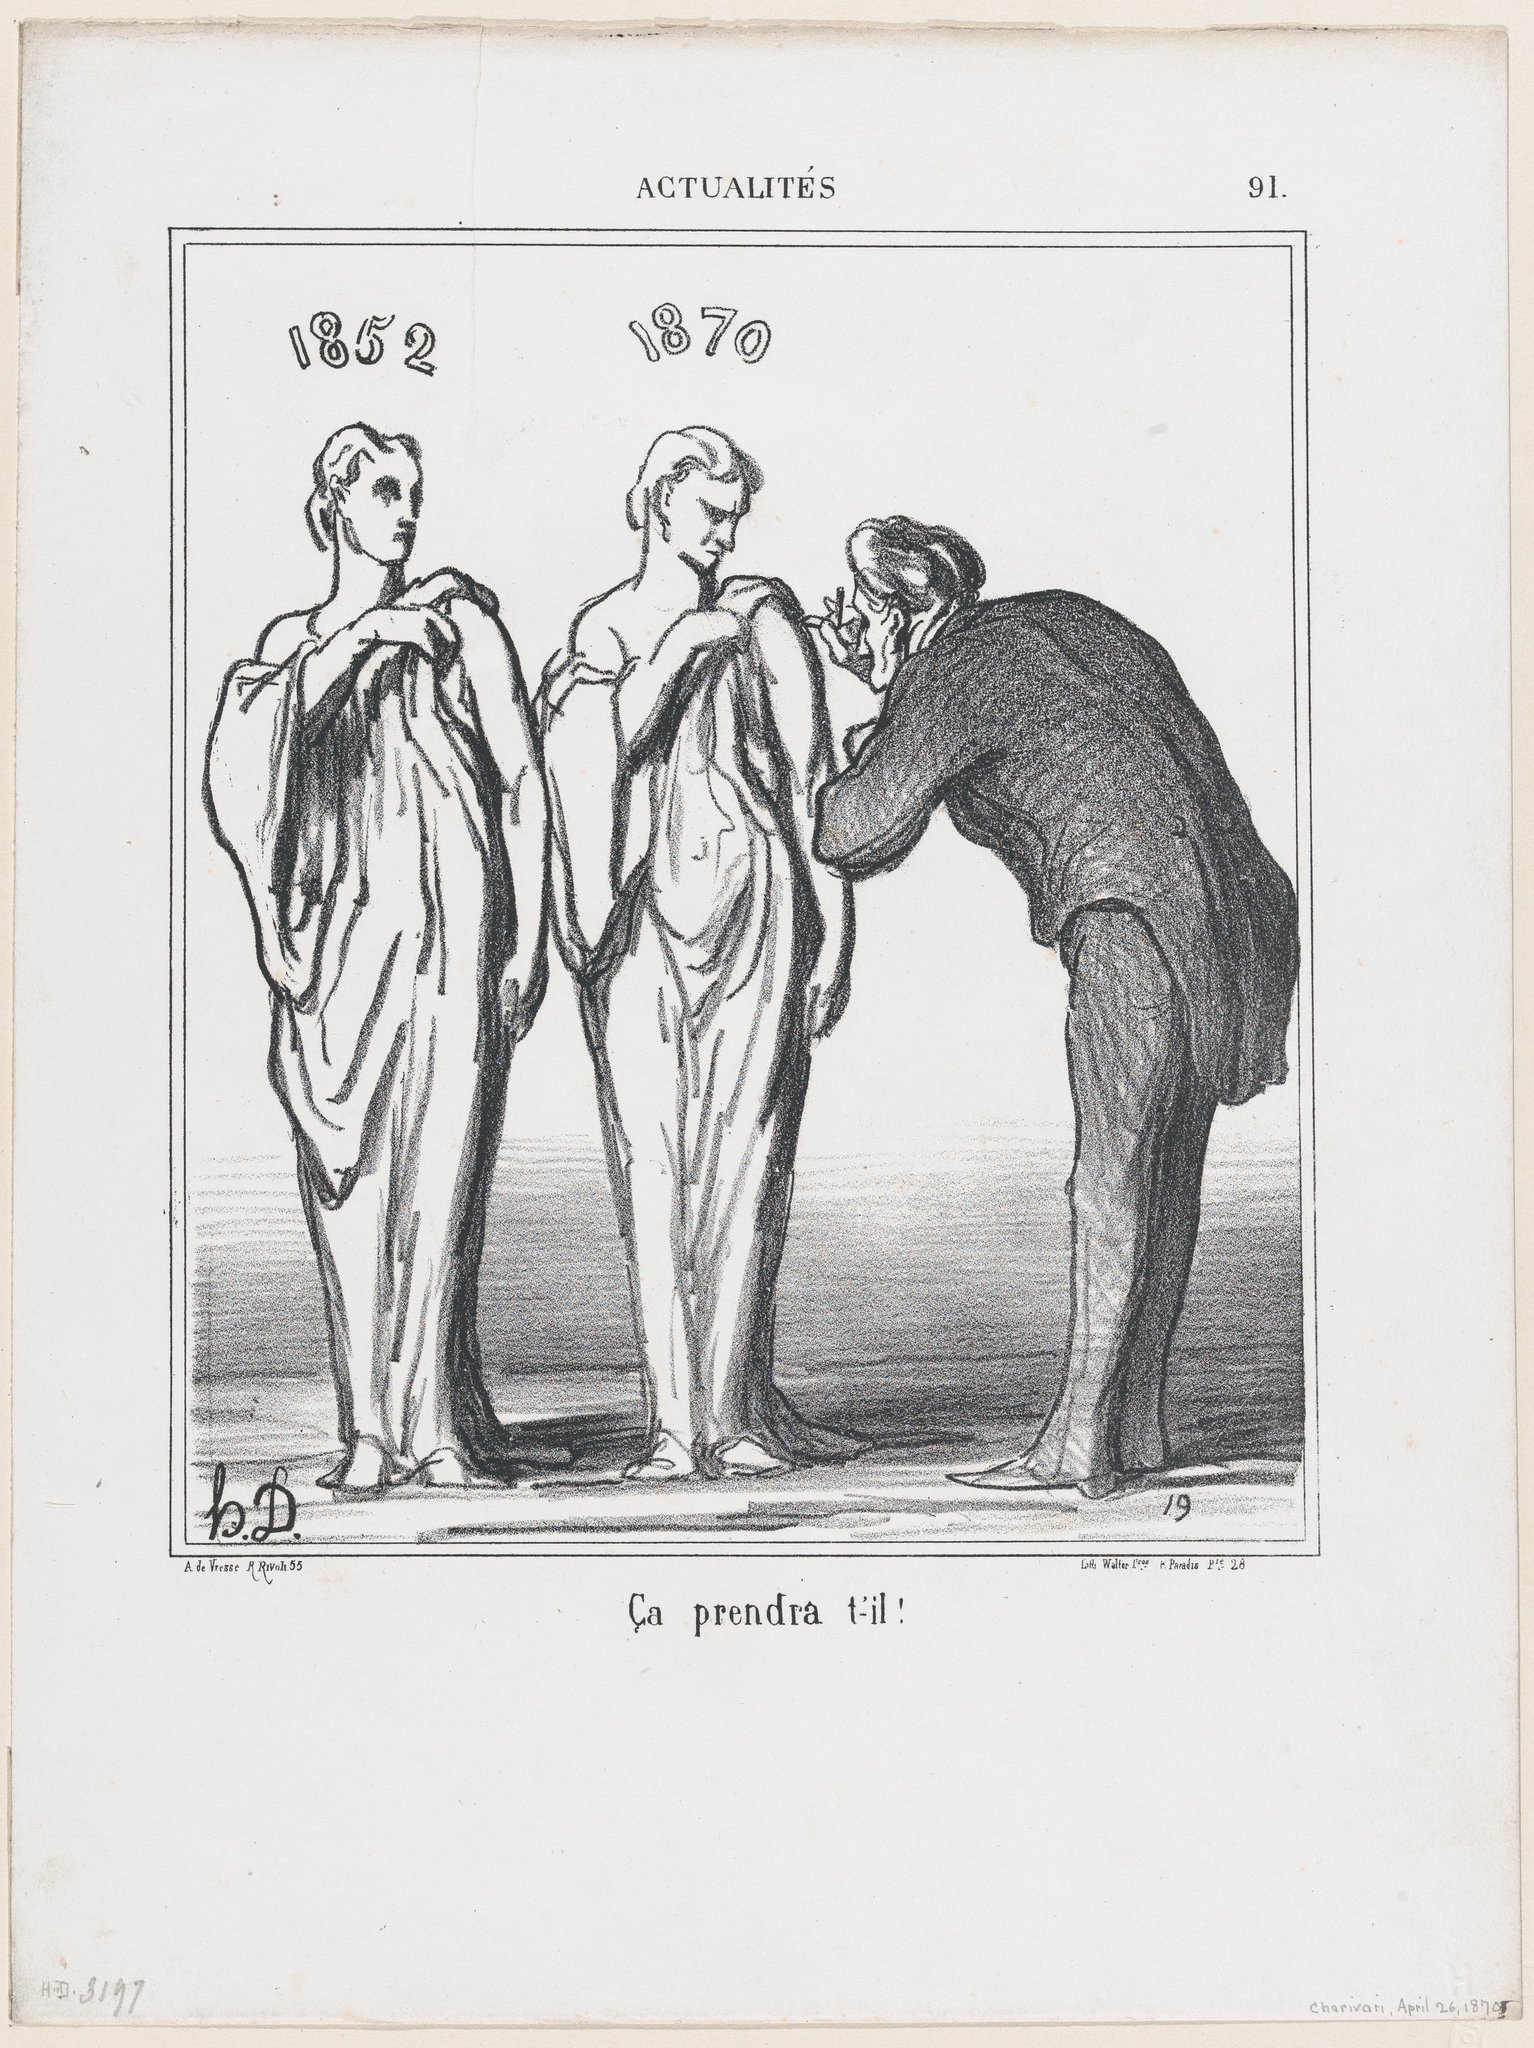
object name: print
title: That will do the job!, from 'News of the day,' published in "Le Charivari"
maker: honoré daumier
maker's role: artist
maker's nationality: french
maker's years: 1808-1879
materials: paper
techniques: lithograph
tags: men